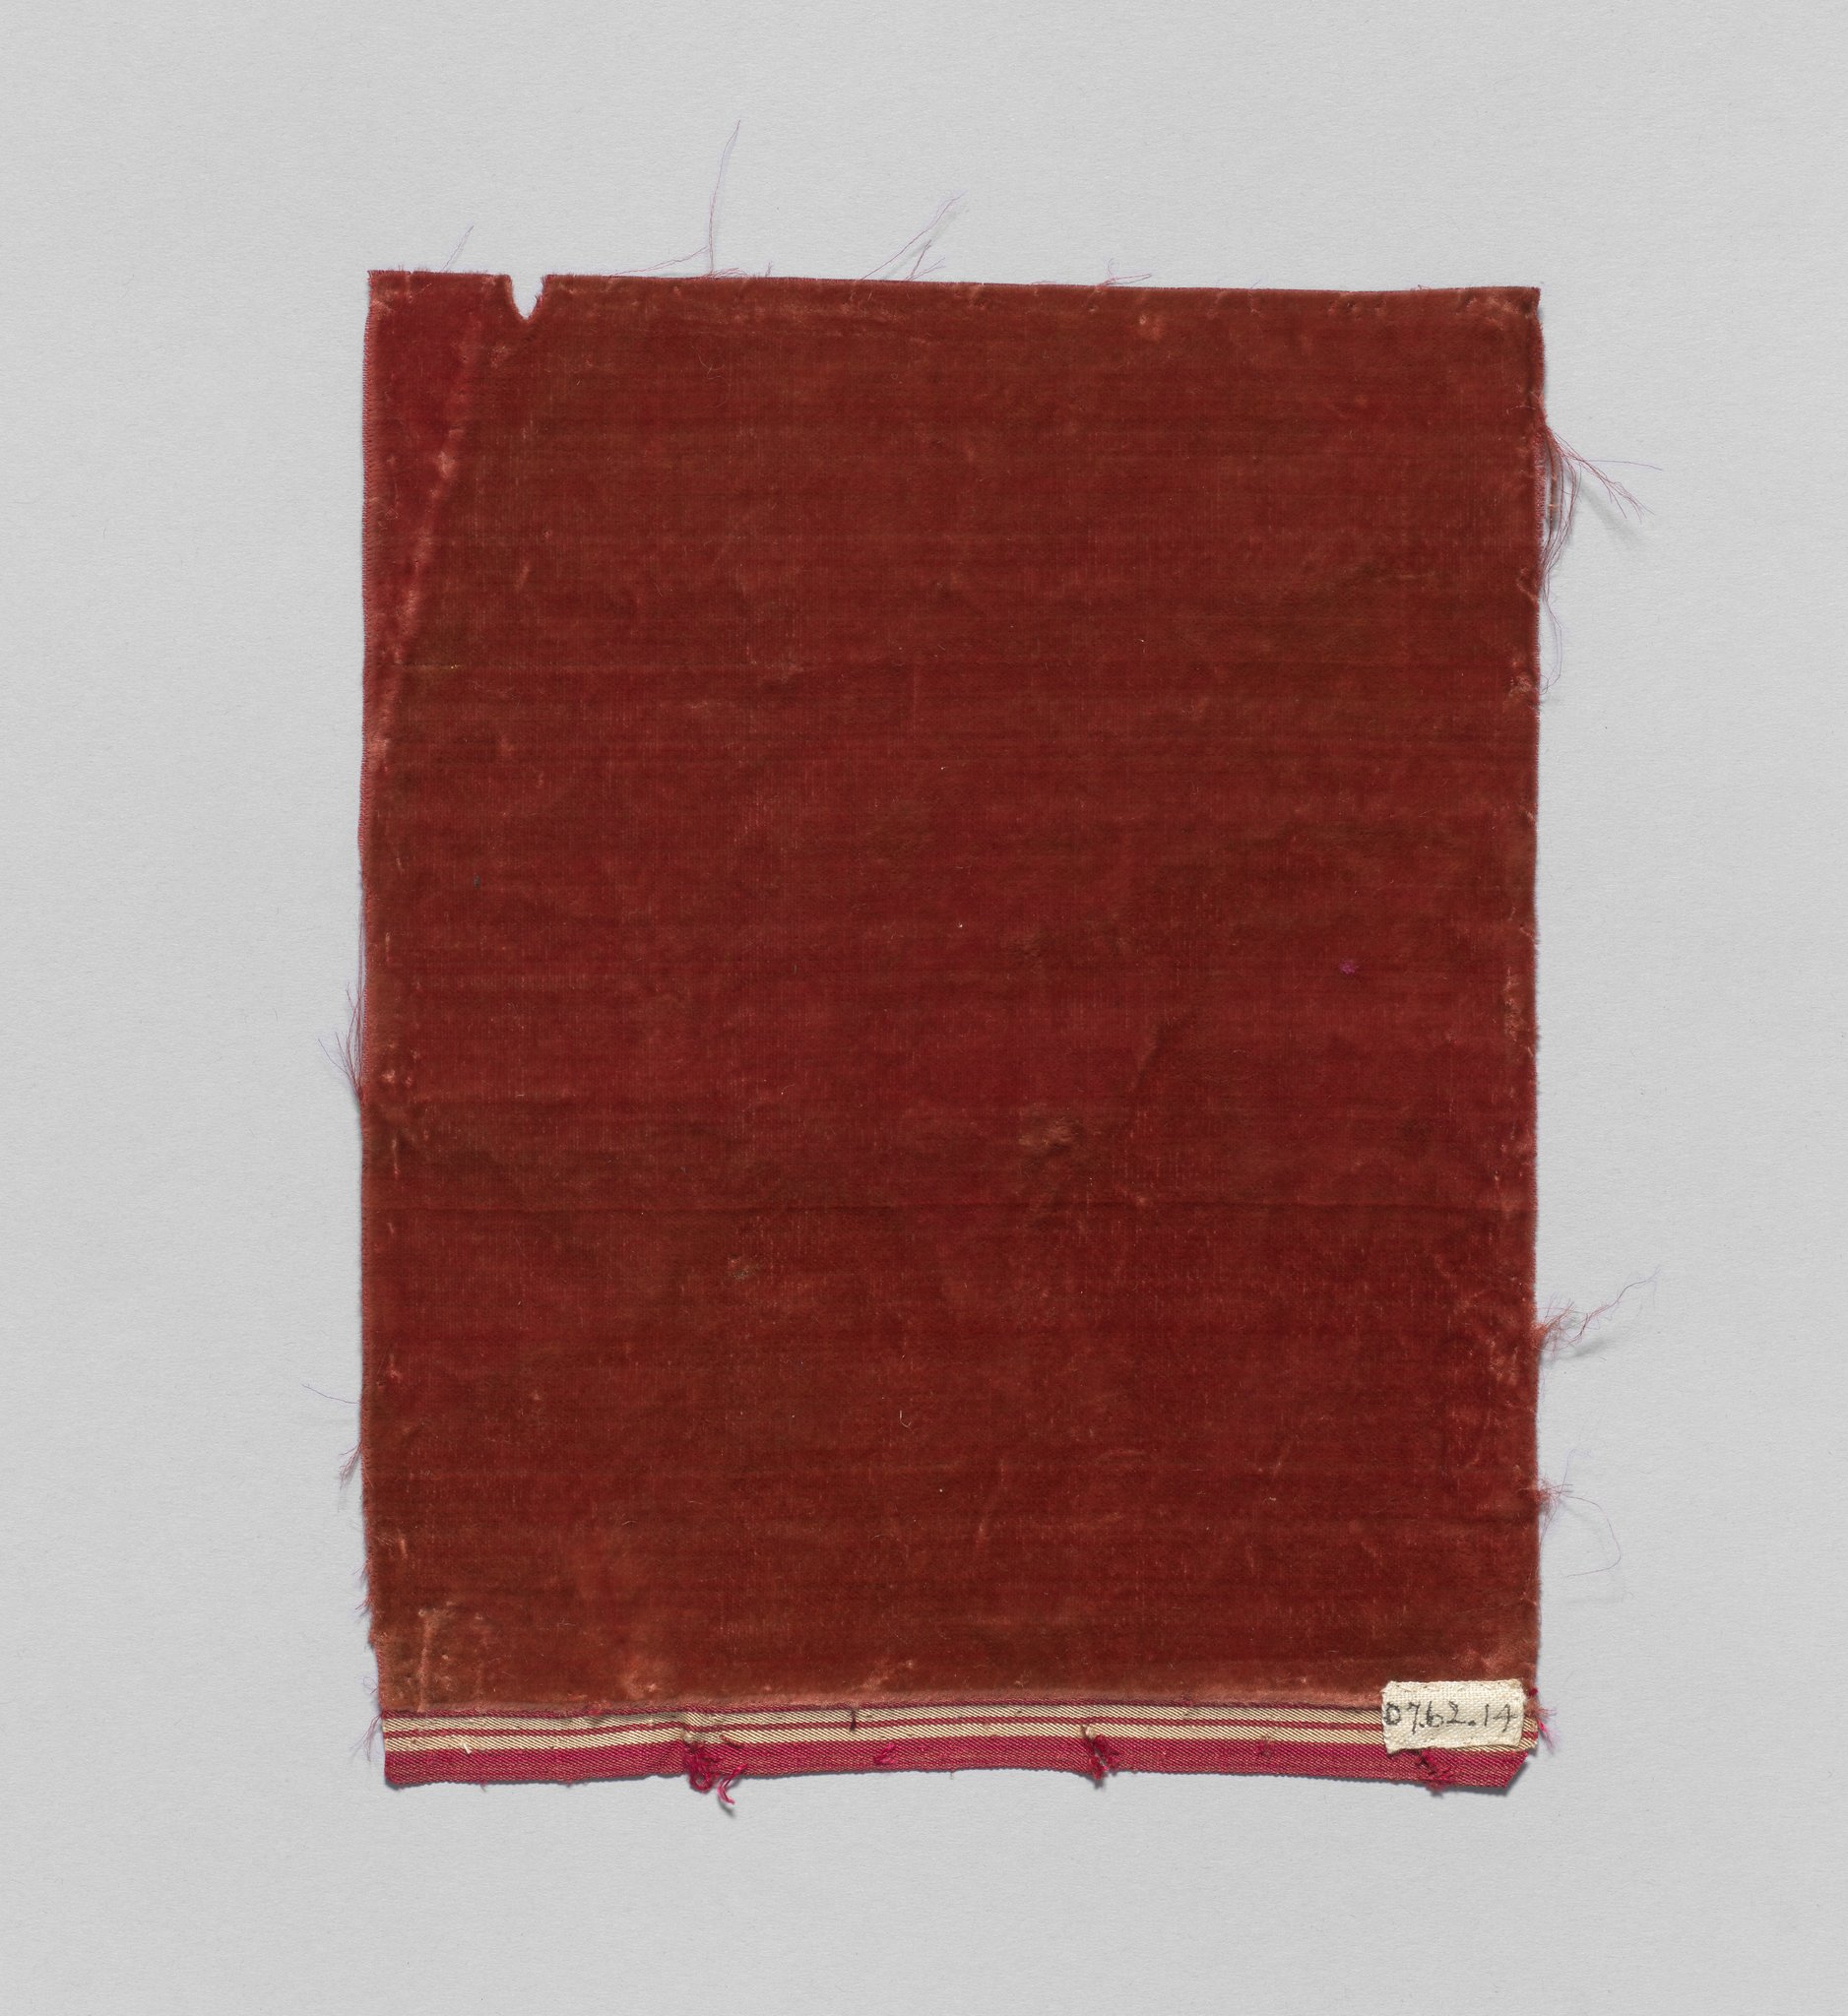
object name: piece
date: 1501-1600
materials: silk